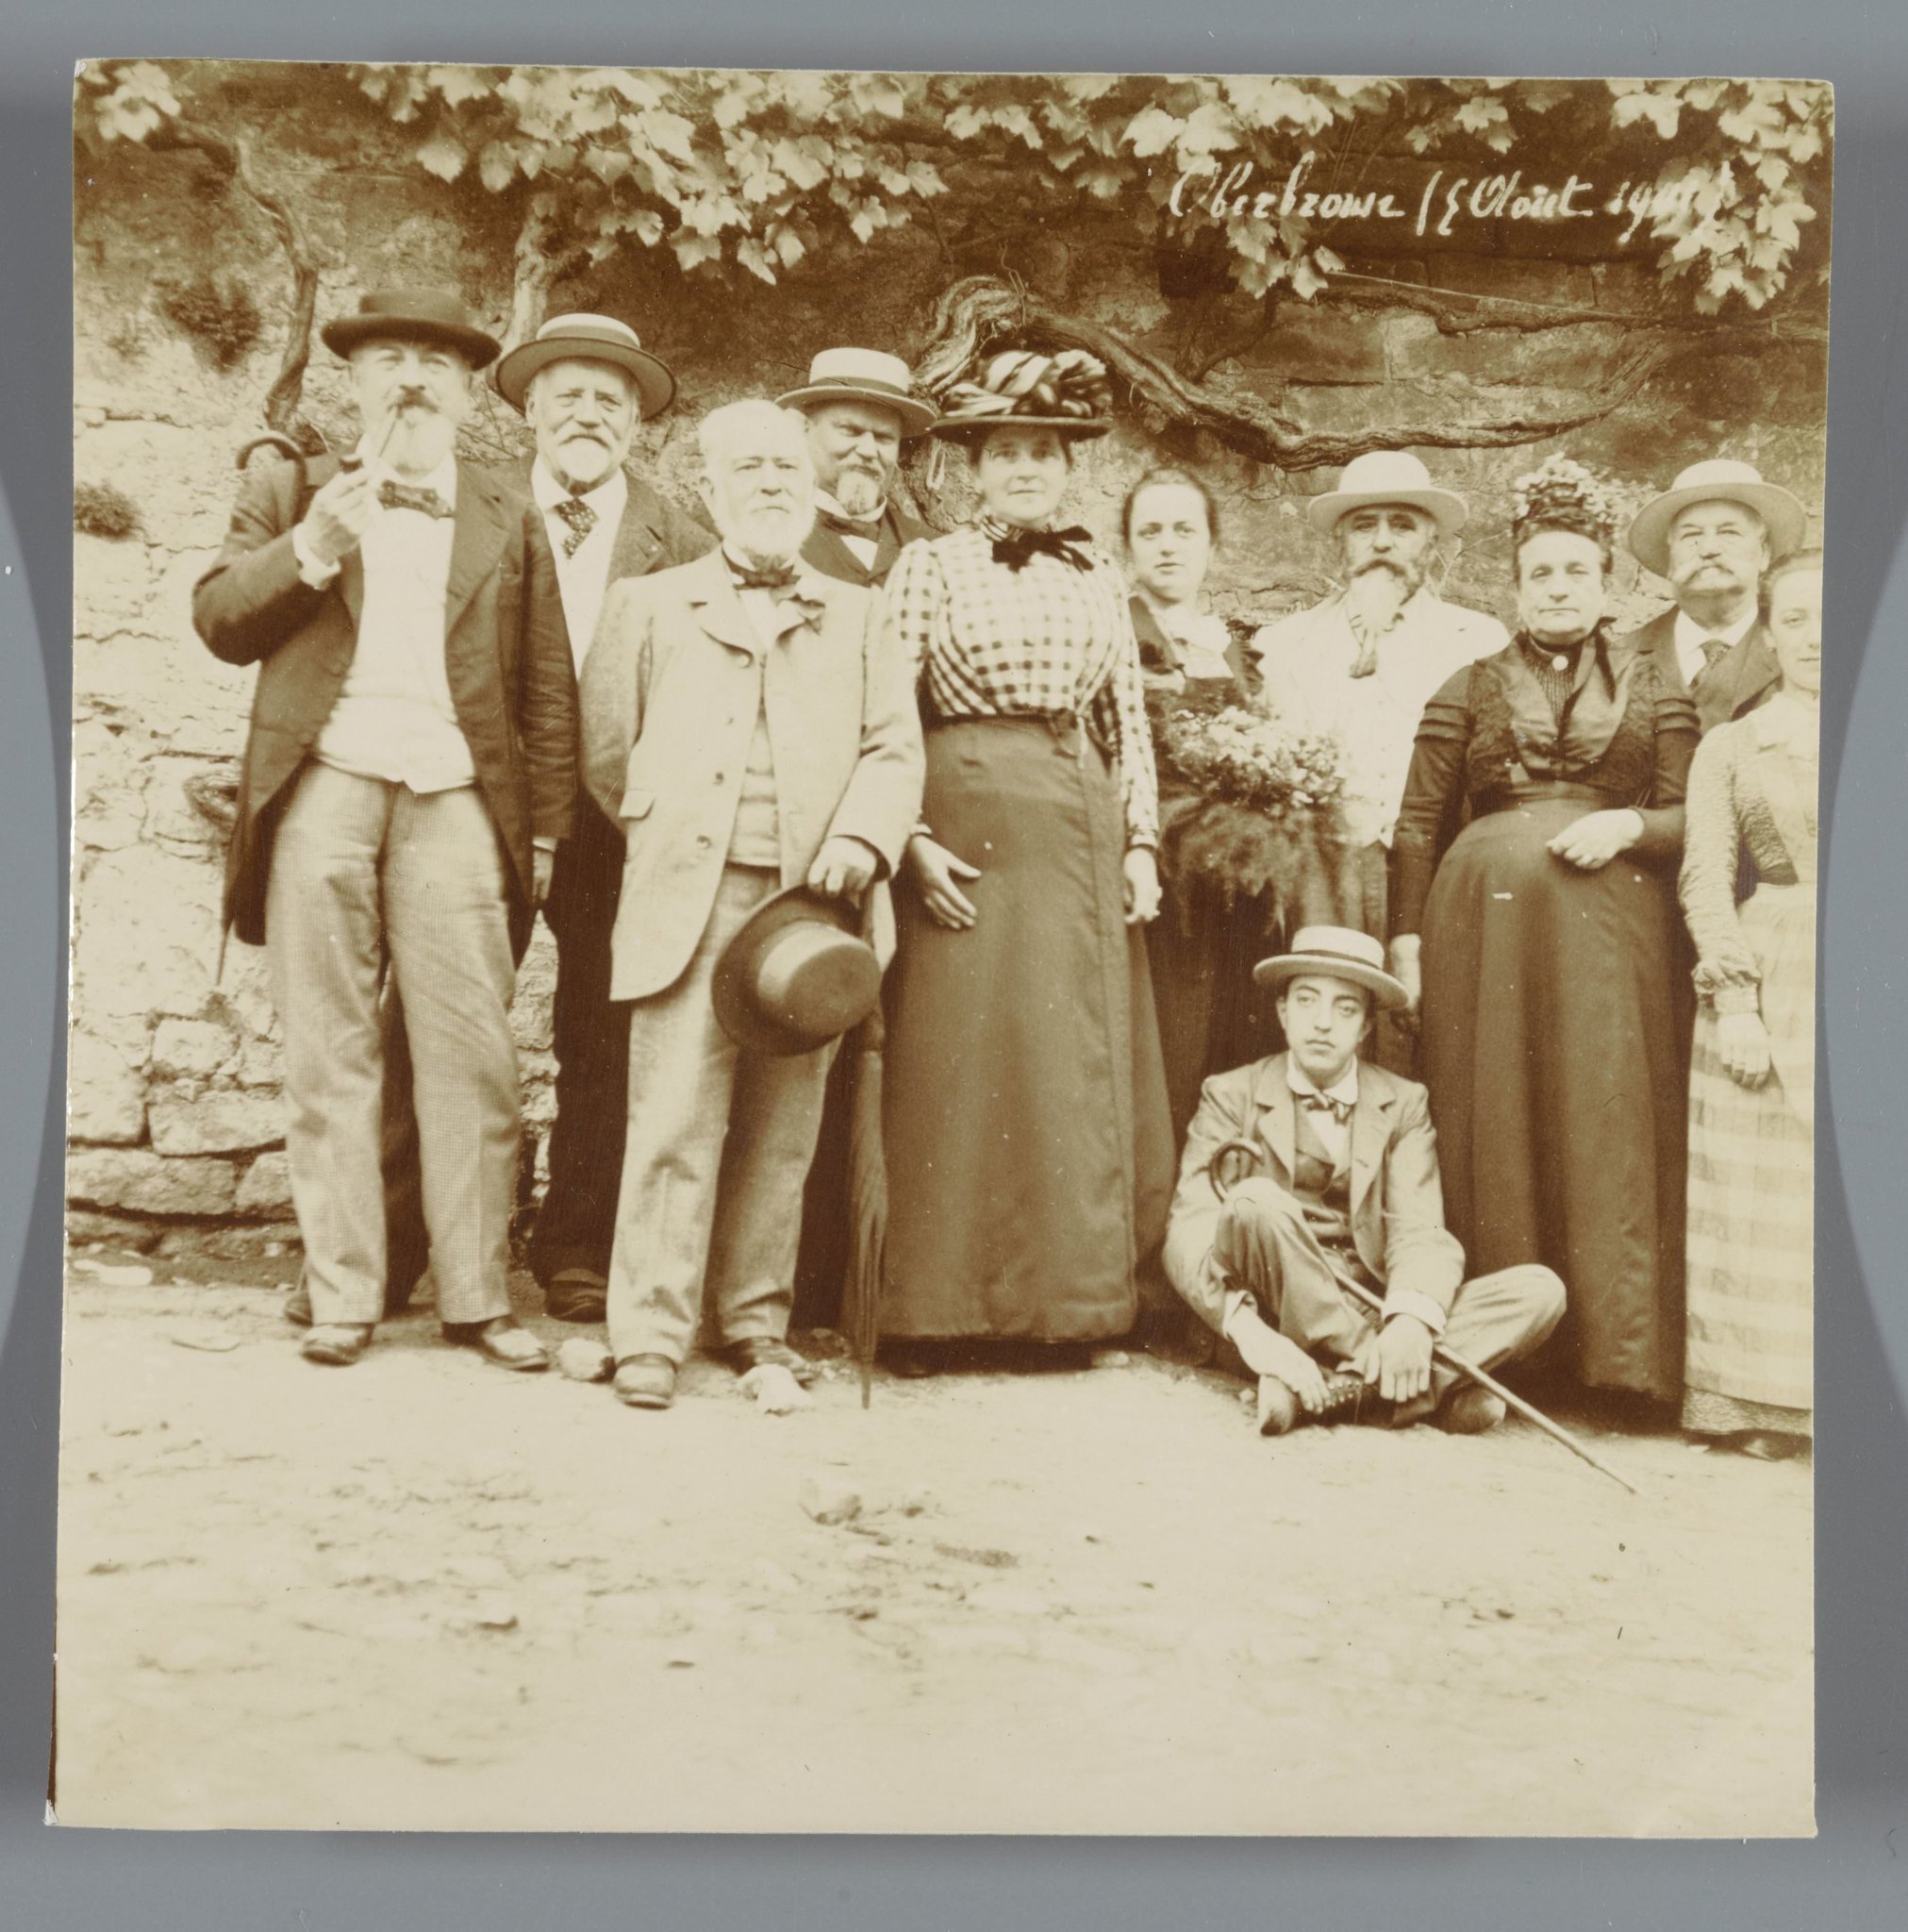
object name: photograph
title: Groepsportret van zeven mannen en vier vrouwen, Oberbronn (Bas-Rhin), Frankrijk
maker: Anonymous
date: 1902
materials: paper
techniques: gelatin silver print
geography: france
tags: public road in village (+ city(-scape) with figures, staffage), france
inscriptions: annotation: ‘Oberbronn 5 Août 1902 [?]’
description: Groepsportret van zeven mannen en vier vrouwen, Oberbronn (Bas-Rhin), Frankrijk.